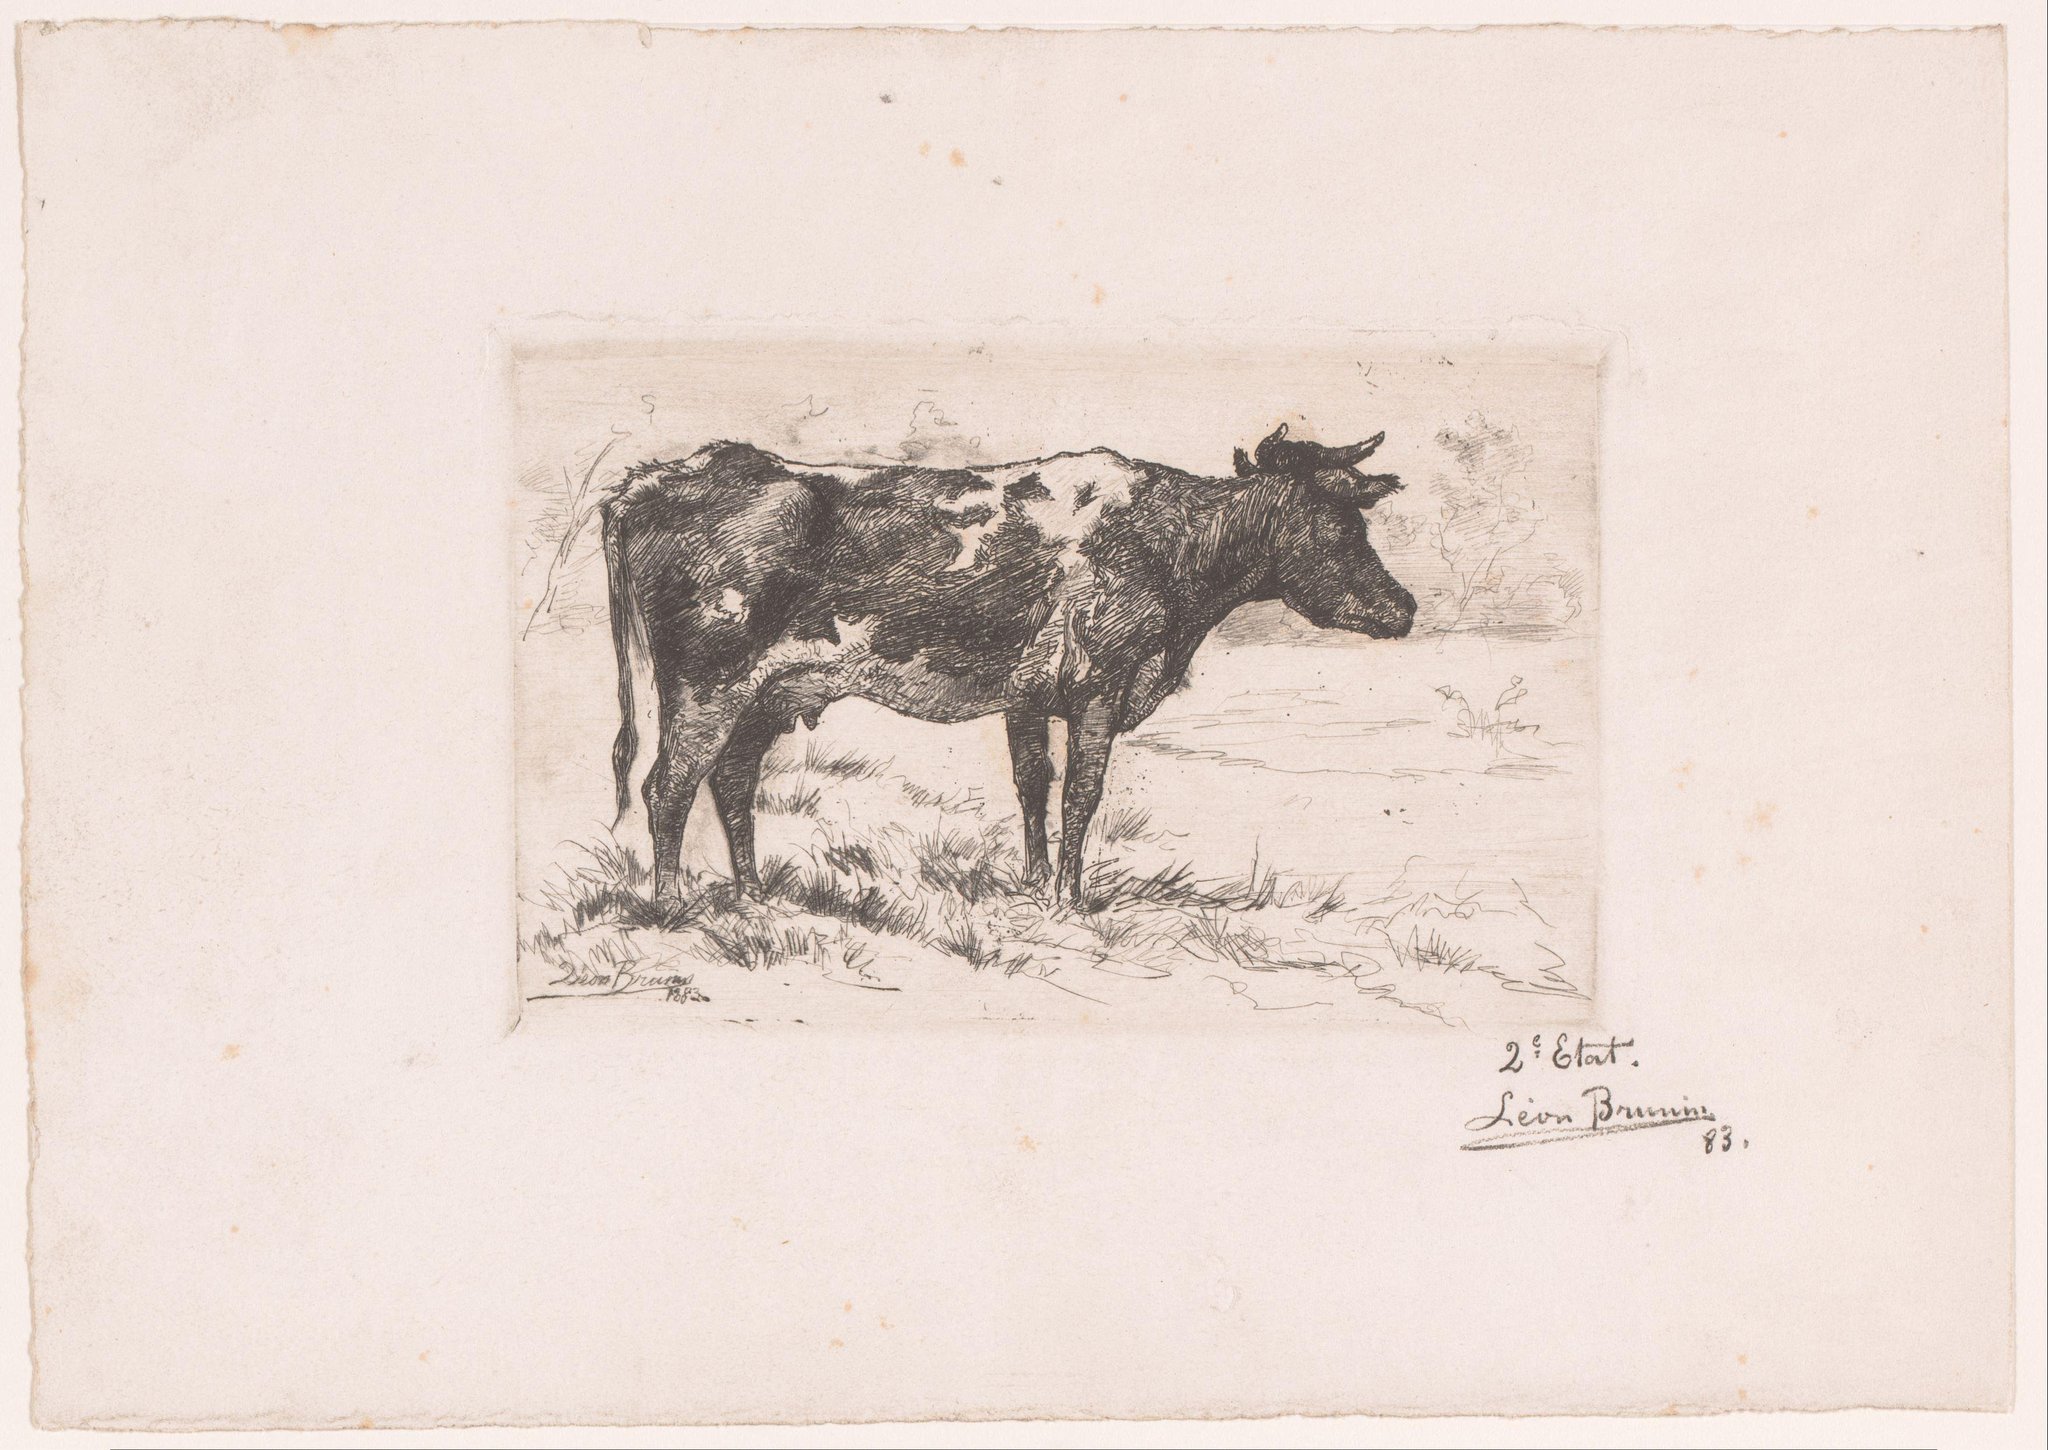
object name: print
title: Koe aan de rand van het water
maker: léon brunin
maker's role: print maker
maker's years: 1861-1949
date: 1883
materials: paper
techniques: etching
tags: cow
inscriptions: collector's mark: Lugt 2228, annotation: ‘2e Etat’